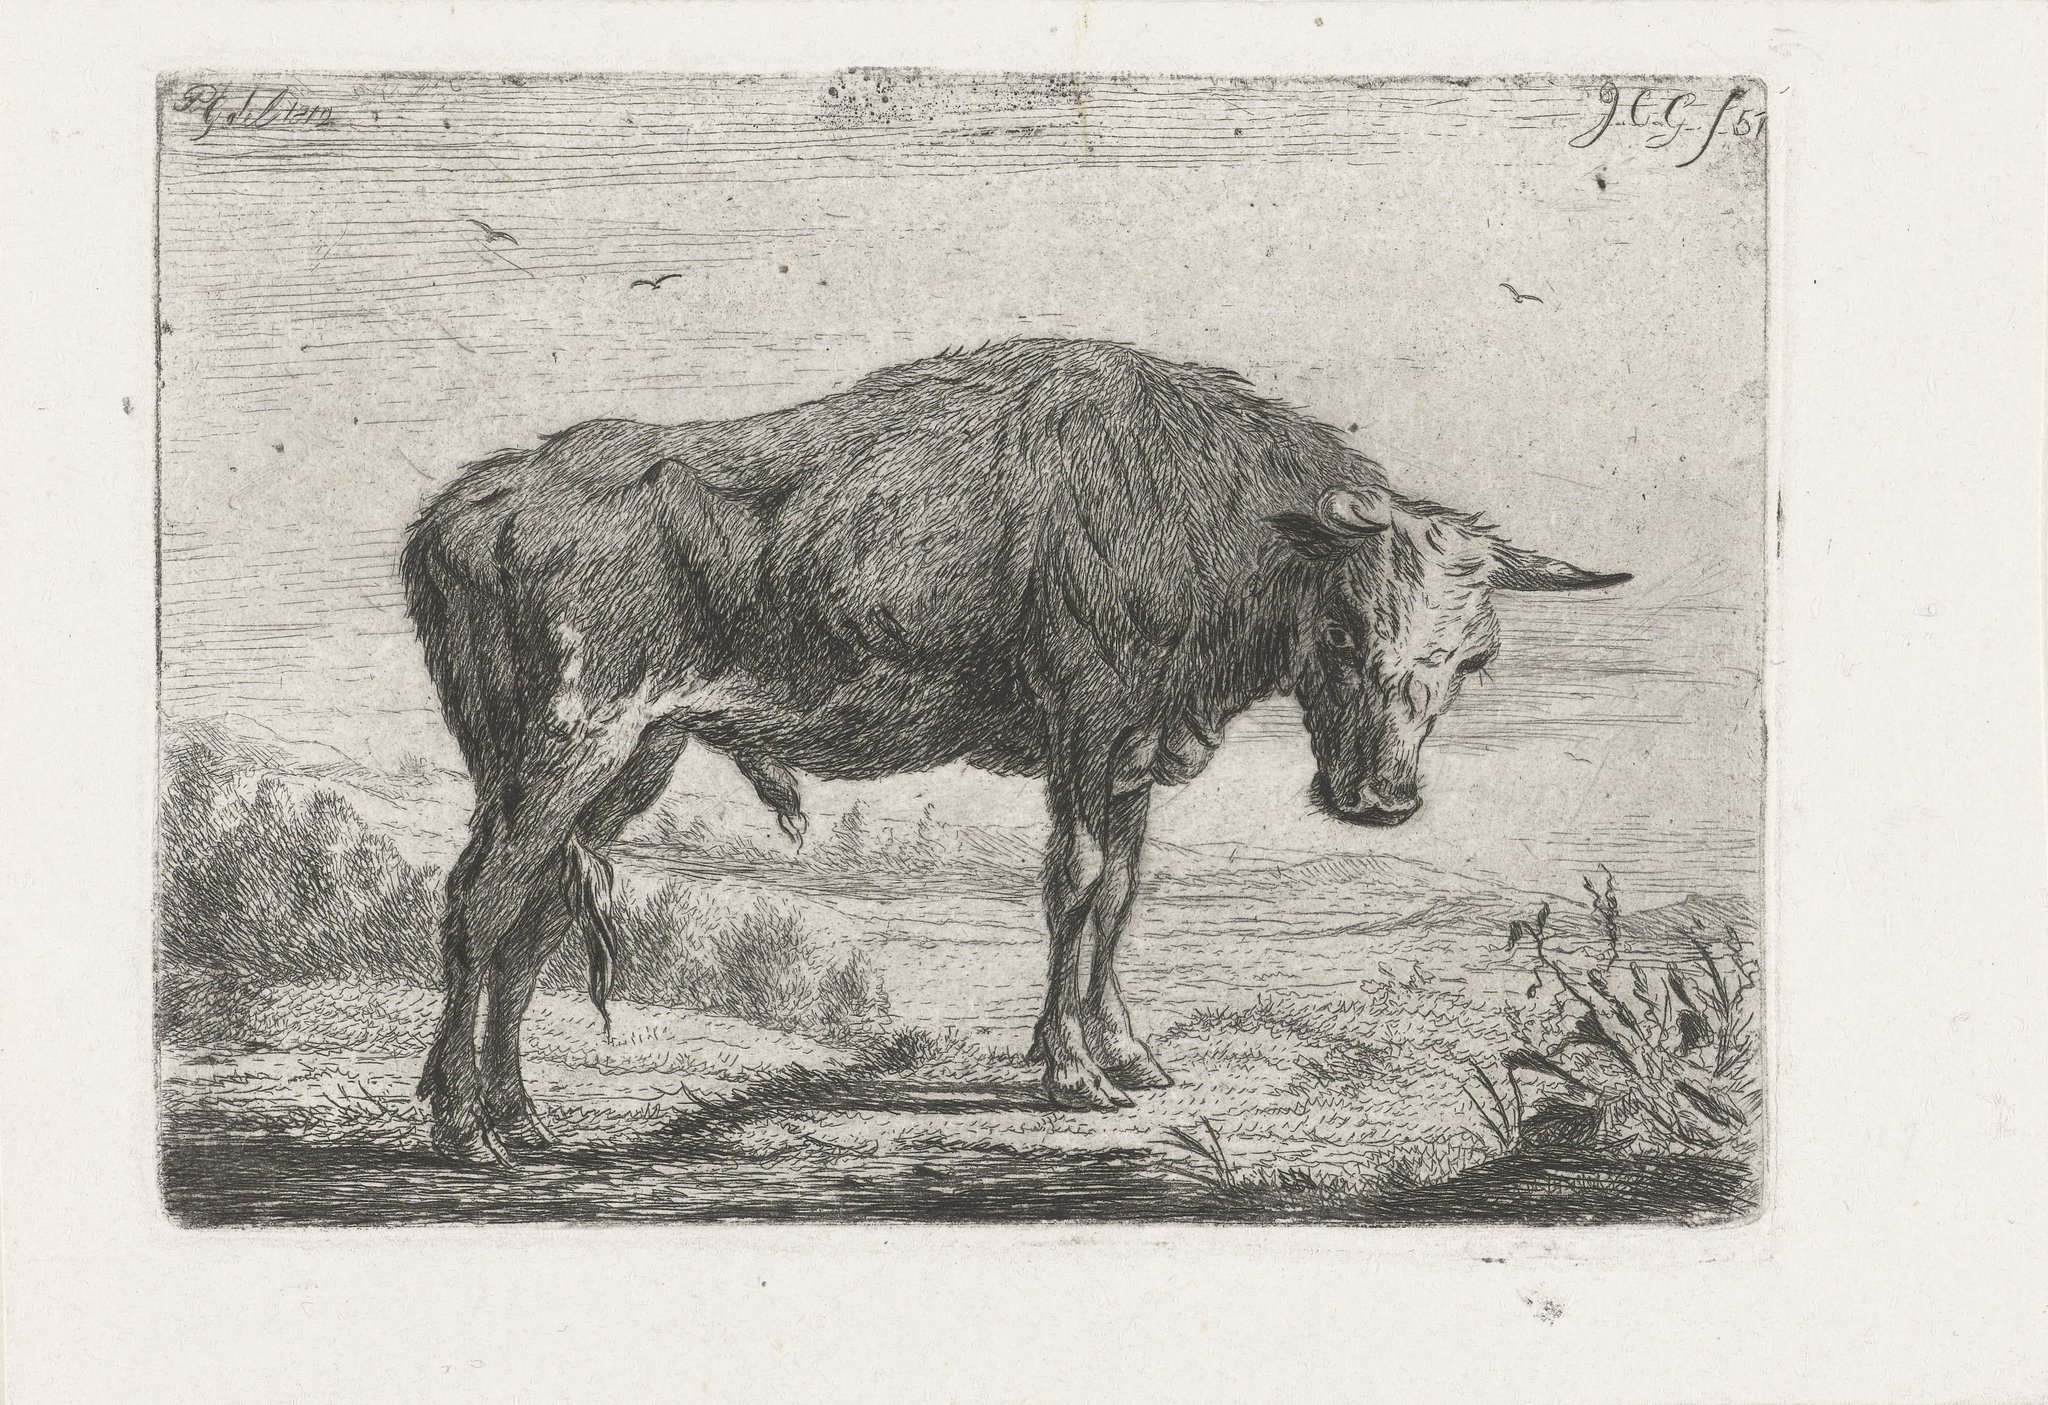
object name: print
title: Staande stier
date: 1851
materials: paper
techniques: etching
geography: netherlands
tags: bull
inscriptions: collector's mark: Lugt 2228